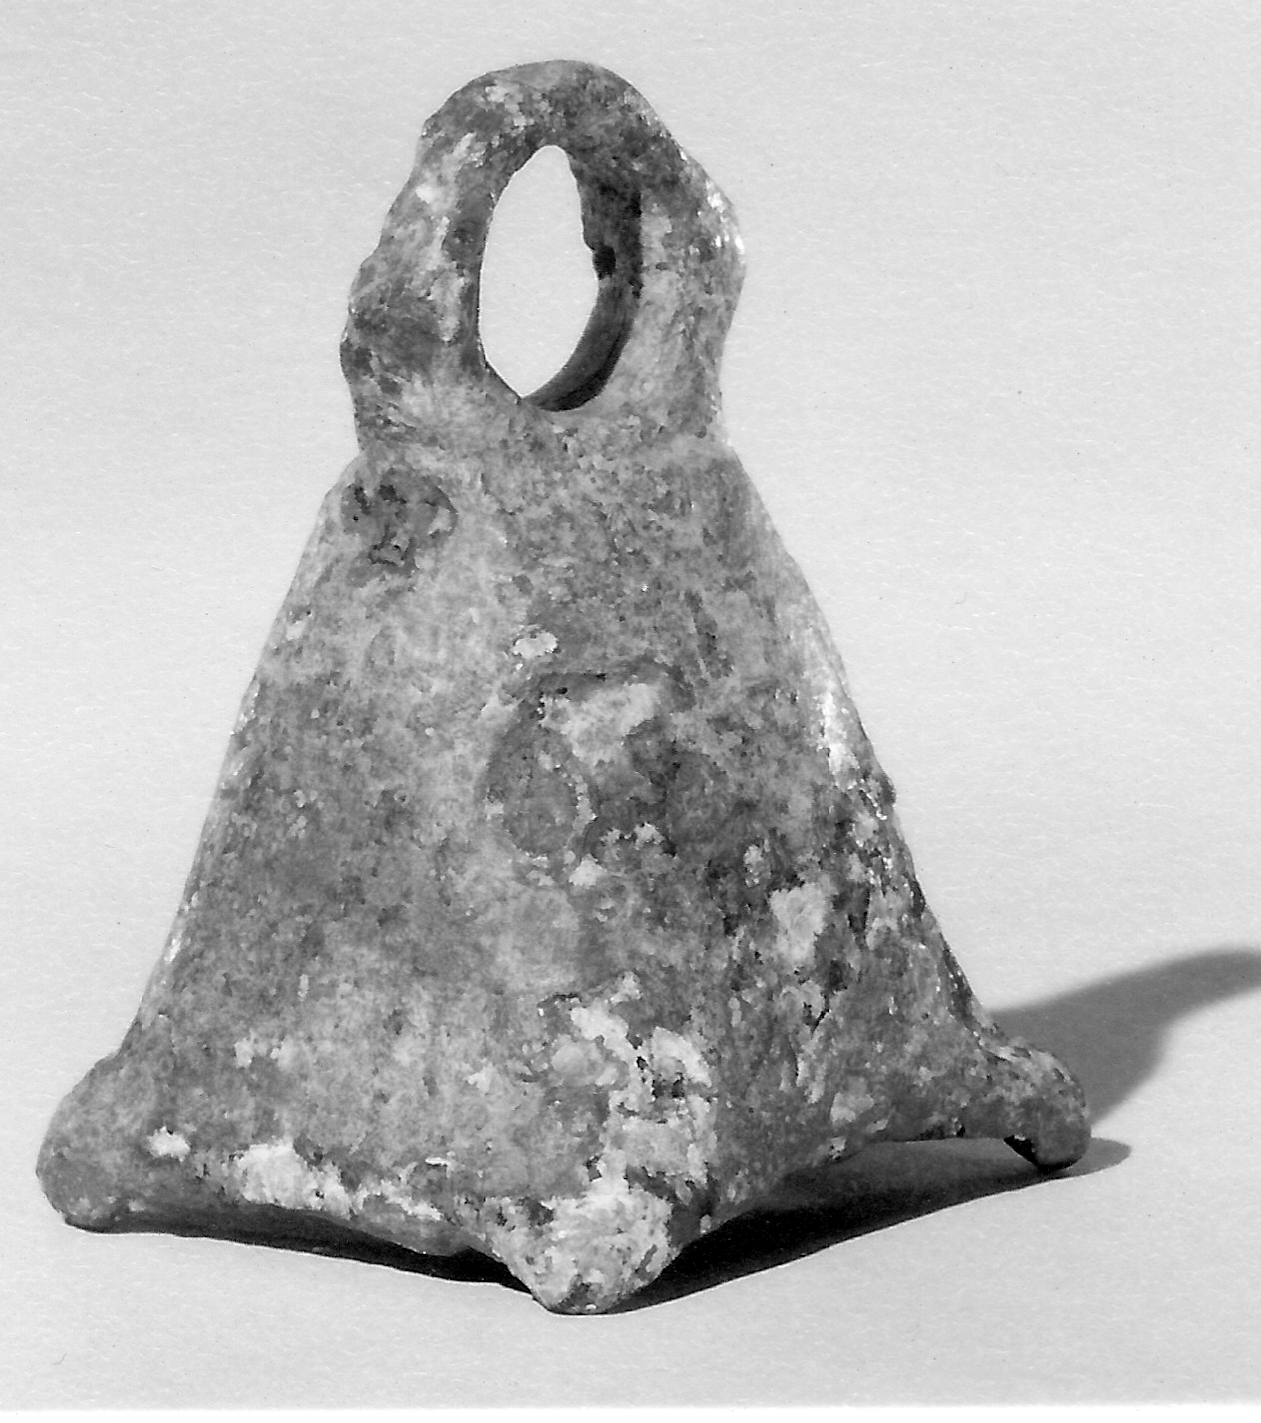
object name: bell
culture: italian, roman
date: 1-100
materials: bronze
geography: italy